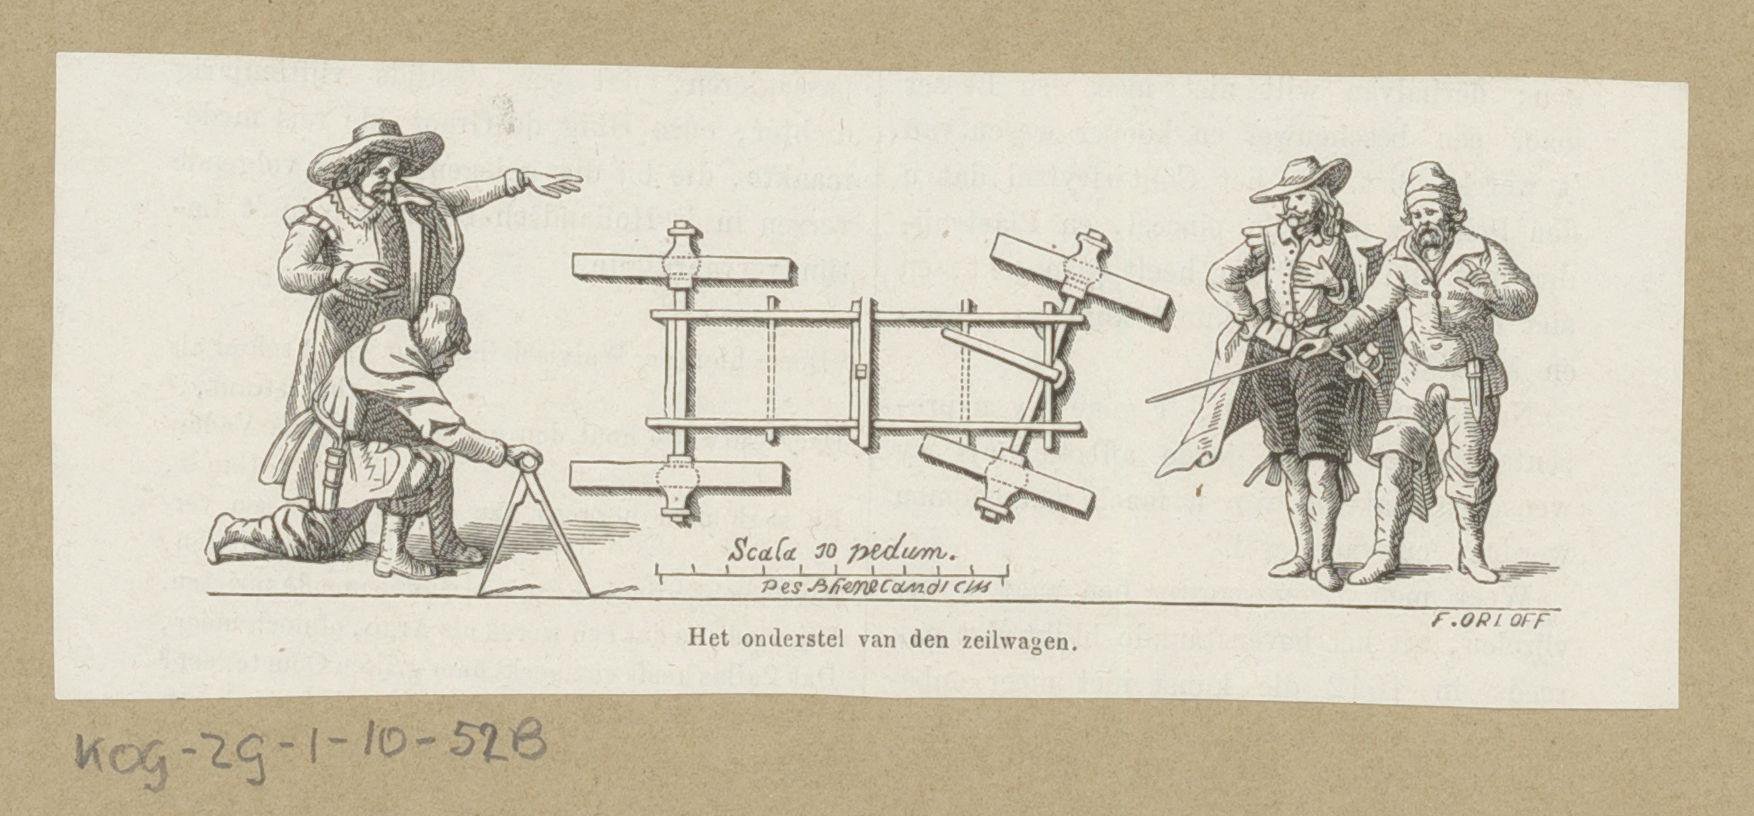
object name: photomechanical print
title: Het onderstel van den zeilwagen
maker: arie cornelis kruseman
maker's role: bookseller, printer, publisher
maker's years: 1818-1894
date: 1869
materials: paper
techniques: letterpress printing, printing block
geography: haarlem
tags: the hague, maurice (prince of orange), simon stevin, sailing-car, measuring-instruments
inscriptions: stamp, stamp, collector's mark: Lugt 1641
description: Aan beide zijden van het onderstel twee mannen. Links heeft een man een passer vast en recht heeft een man een duimstok. Onderwerpsrubrieken binnen de Atlas Zeden en Gewoonten: Vervoermiddelen te land en te water, Vervoermiddelen te land, Zeilwagen van Simon Stevin.